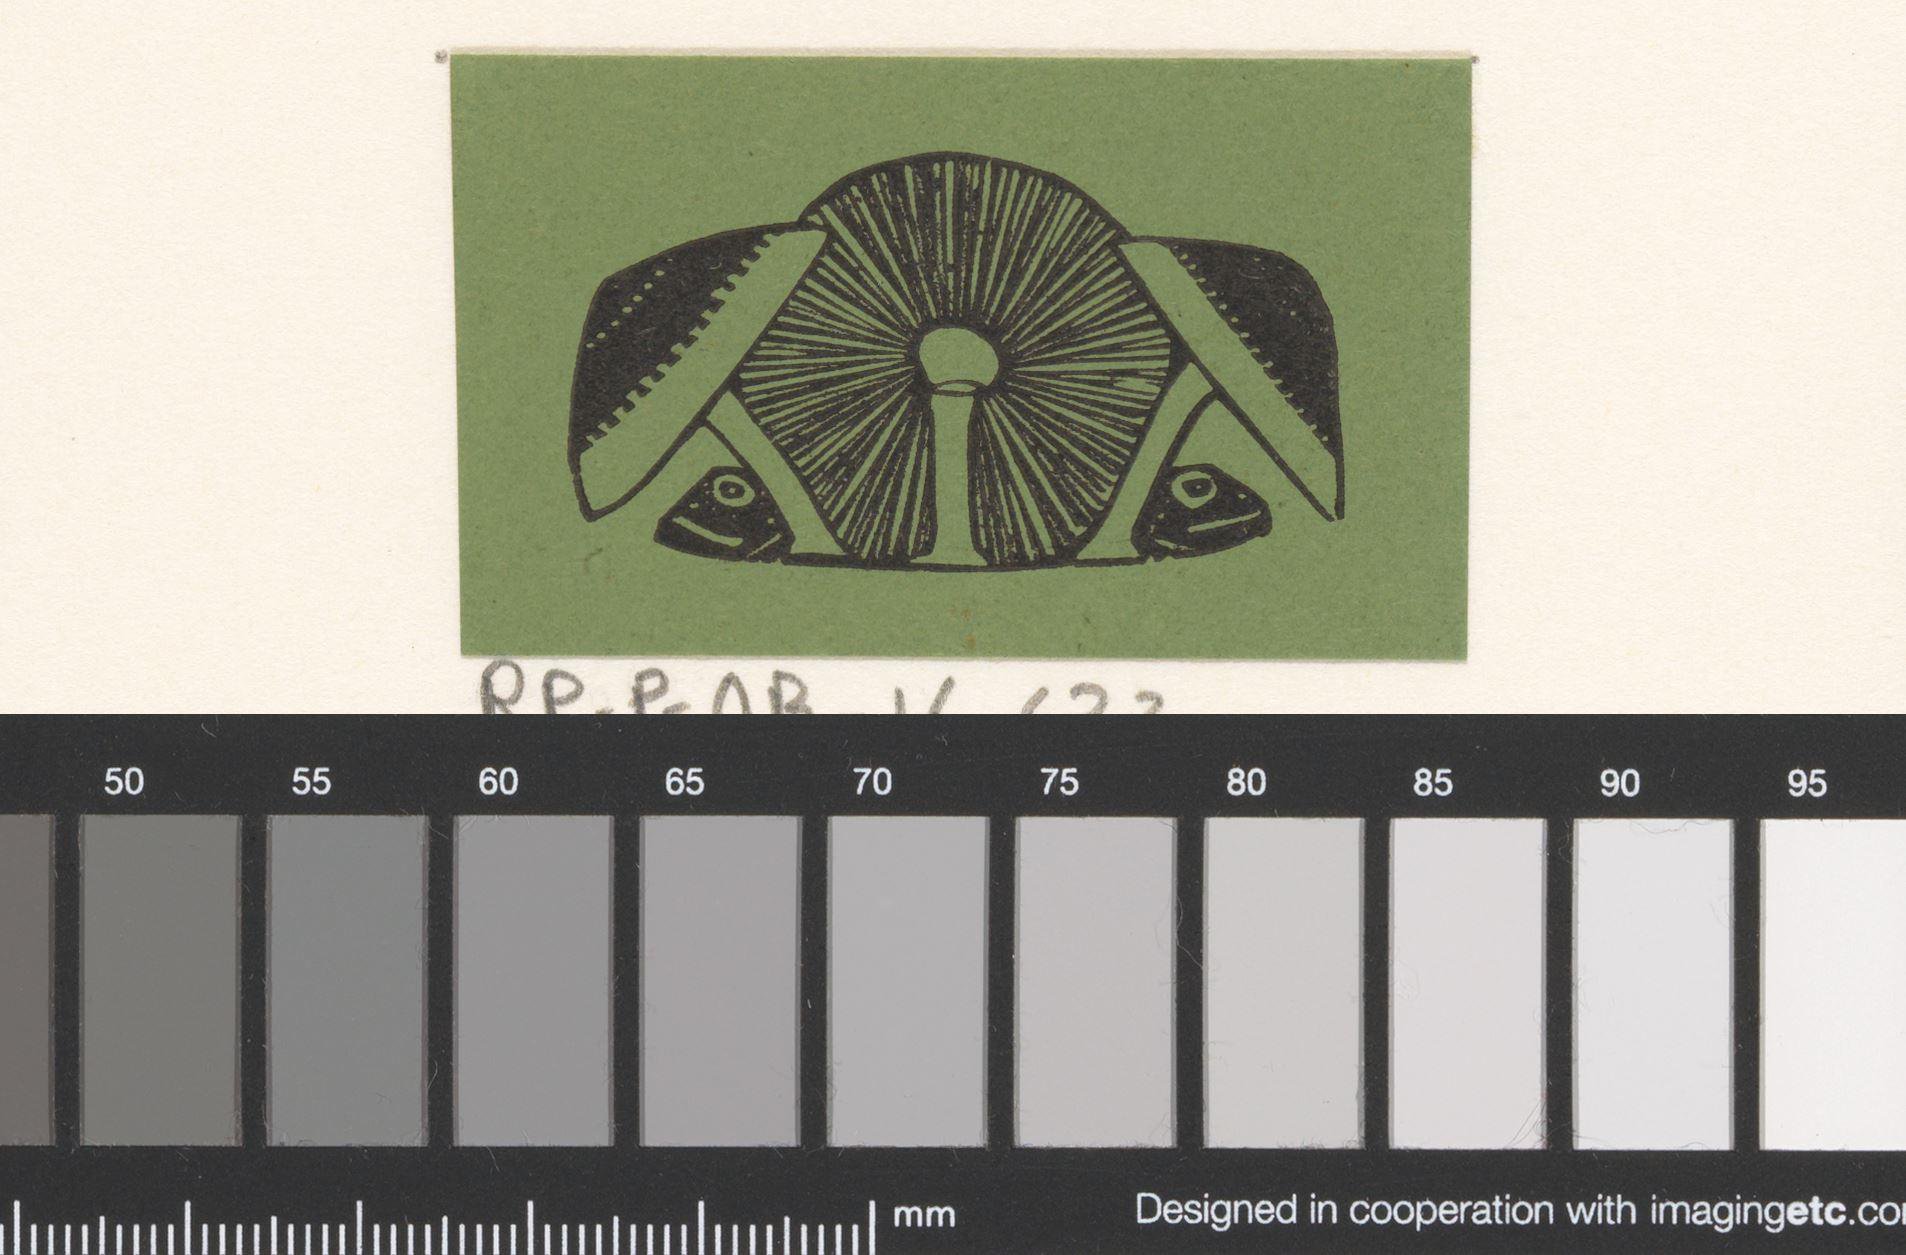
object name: print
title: Vignet met drie paddenstoelen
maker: gerrit willem dijsselhof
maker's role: designer, draughtsman, print maker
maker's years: 1866-1924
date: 1892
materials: paper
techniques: woodcut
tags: mushrooms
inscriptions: collector's mark: Lugt 2228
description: Gerrit Willem Dijsselhof vervaardigde zevenentwintig vignetten voor de gedichtenbundel 'Verzen' van Willem Kloos, die zou verschijnen bij de uitgeverij W. Versluys. Dit vignet is er daar één van. Hoewel de uitvoering van het boek in een ver stadium was, is het uiteindelijk nooit verschenen. De vignetten zijn later wel voor diverse andere doeleinden gebruikt.